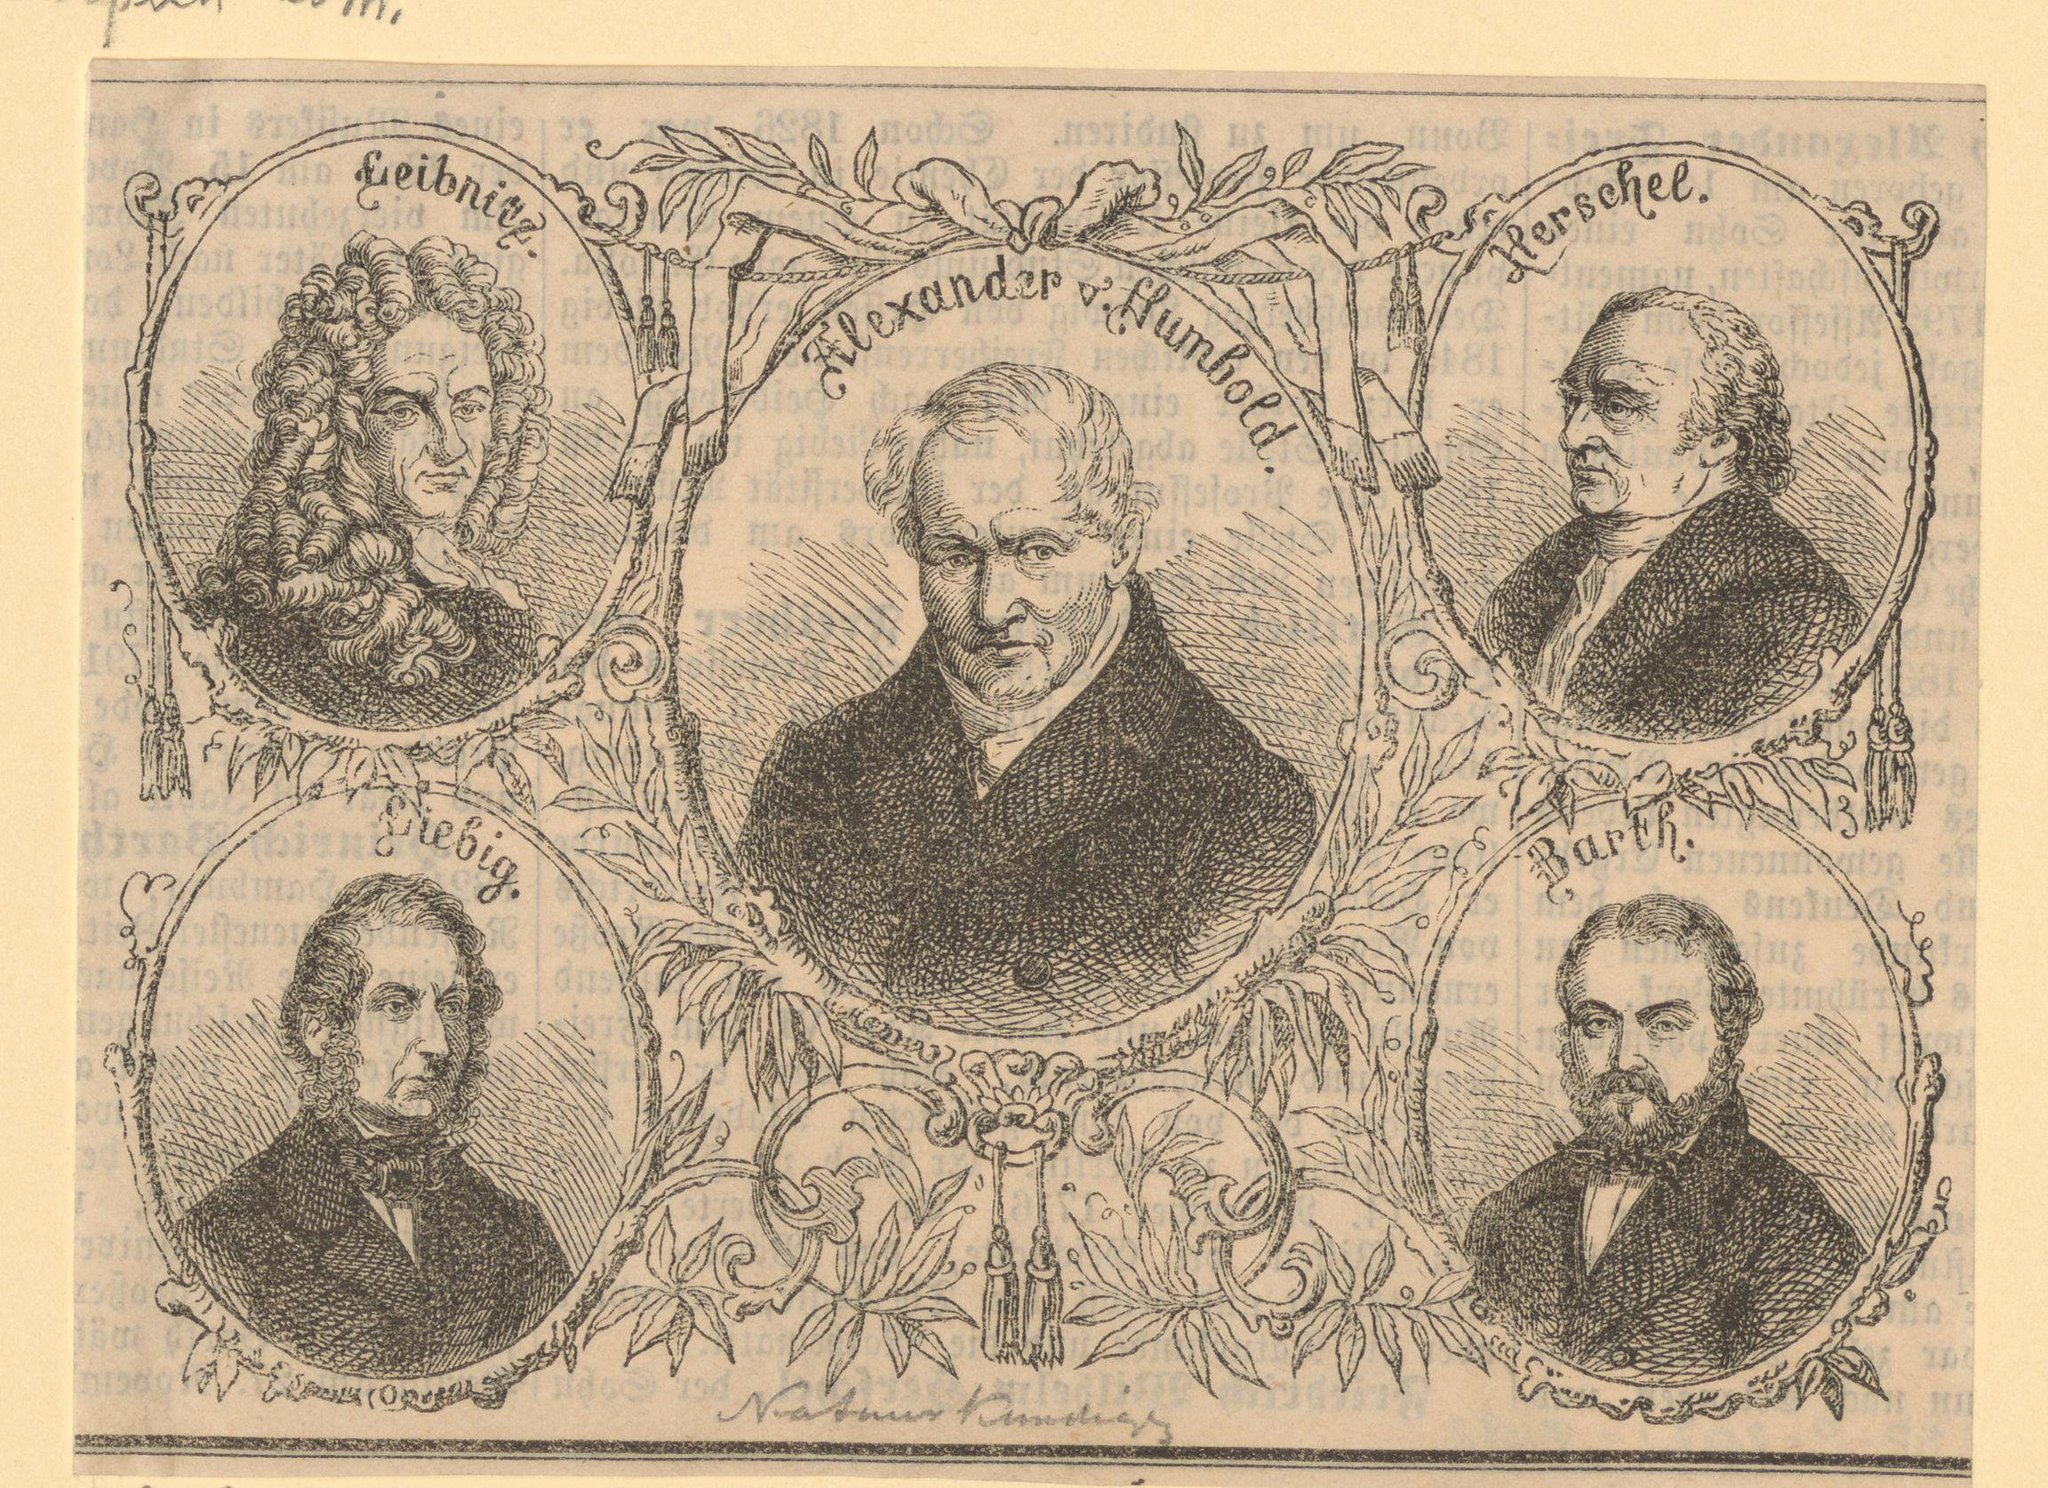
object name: print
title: Portretten van Alexander von Humboldt, Gottfried Wilhelm Leibniz, Justus von Liebig, Frederick William Herschel en Heinrich Barth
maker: Anonymous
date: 1867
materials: paper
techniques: letterpress printing, engraving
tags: berlin, scholar, philosopher, historical persons, biology (+ portrait of scholar, scientist)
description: Prent uit: Illustrirter Familien-Kalender, 1867.